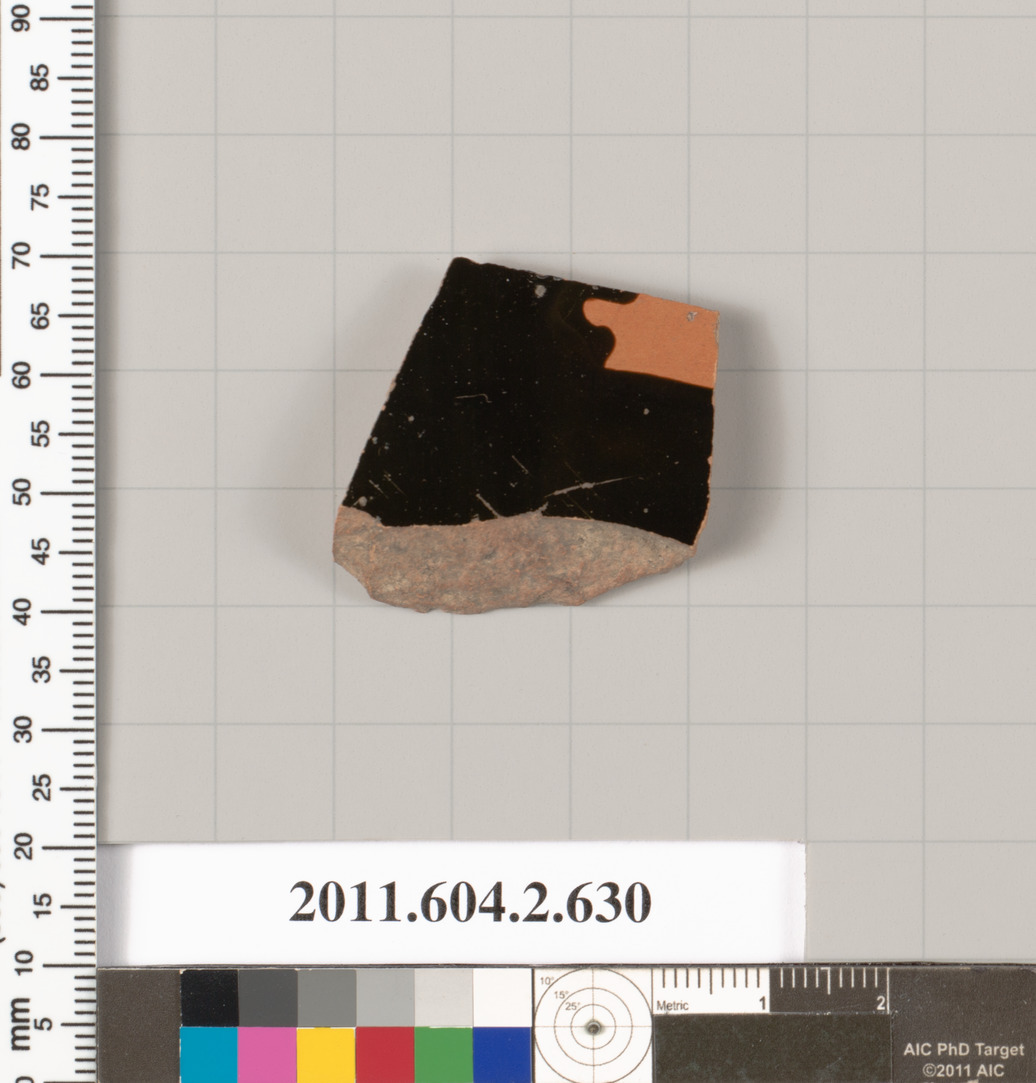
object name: column krater fragment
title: Terracotta fragment of a column-krater (bowl for mixing wine and water)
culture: greek, attic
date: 460-440 BCE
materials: terracotta